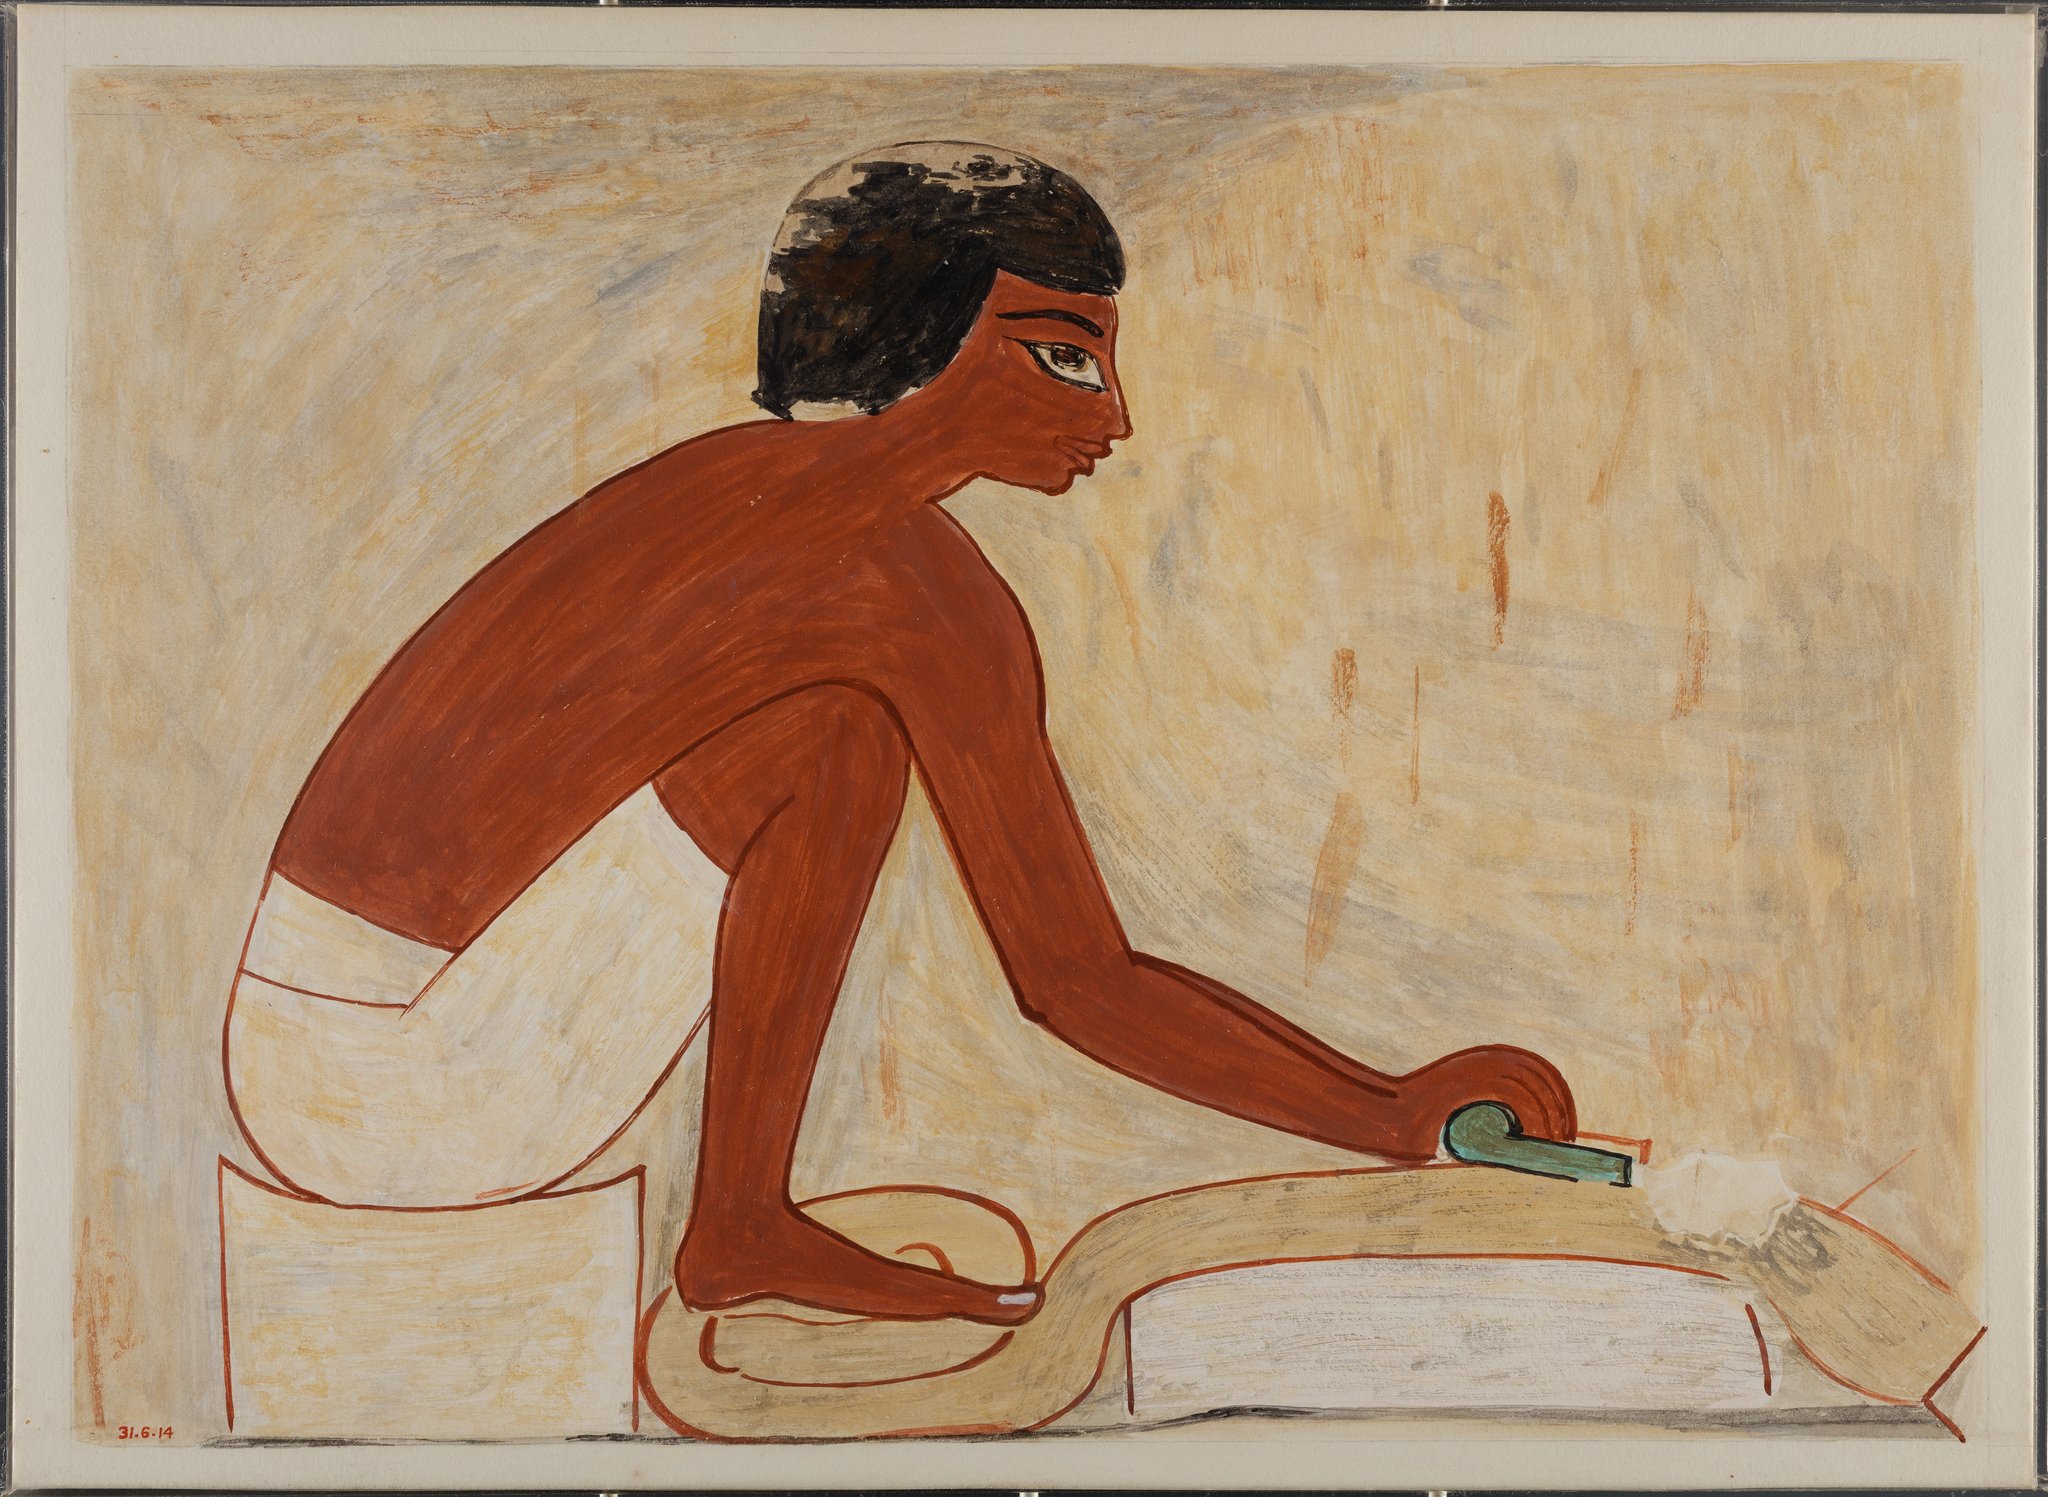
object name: facsimile, rekhmire tt 100, leather work, sandal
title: Leather Working, Tomb of Rekhmire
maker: nina de garis davies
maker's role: artist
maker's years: 1881-1965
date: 1504-1425 BCE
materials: ink, paint, paper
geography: egypt